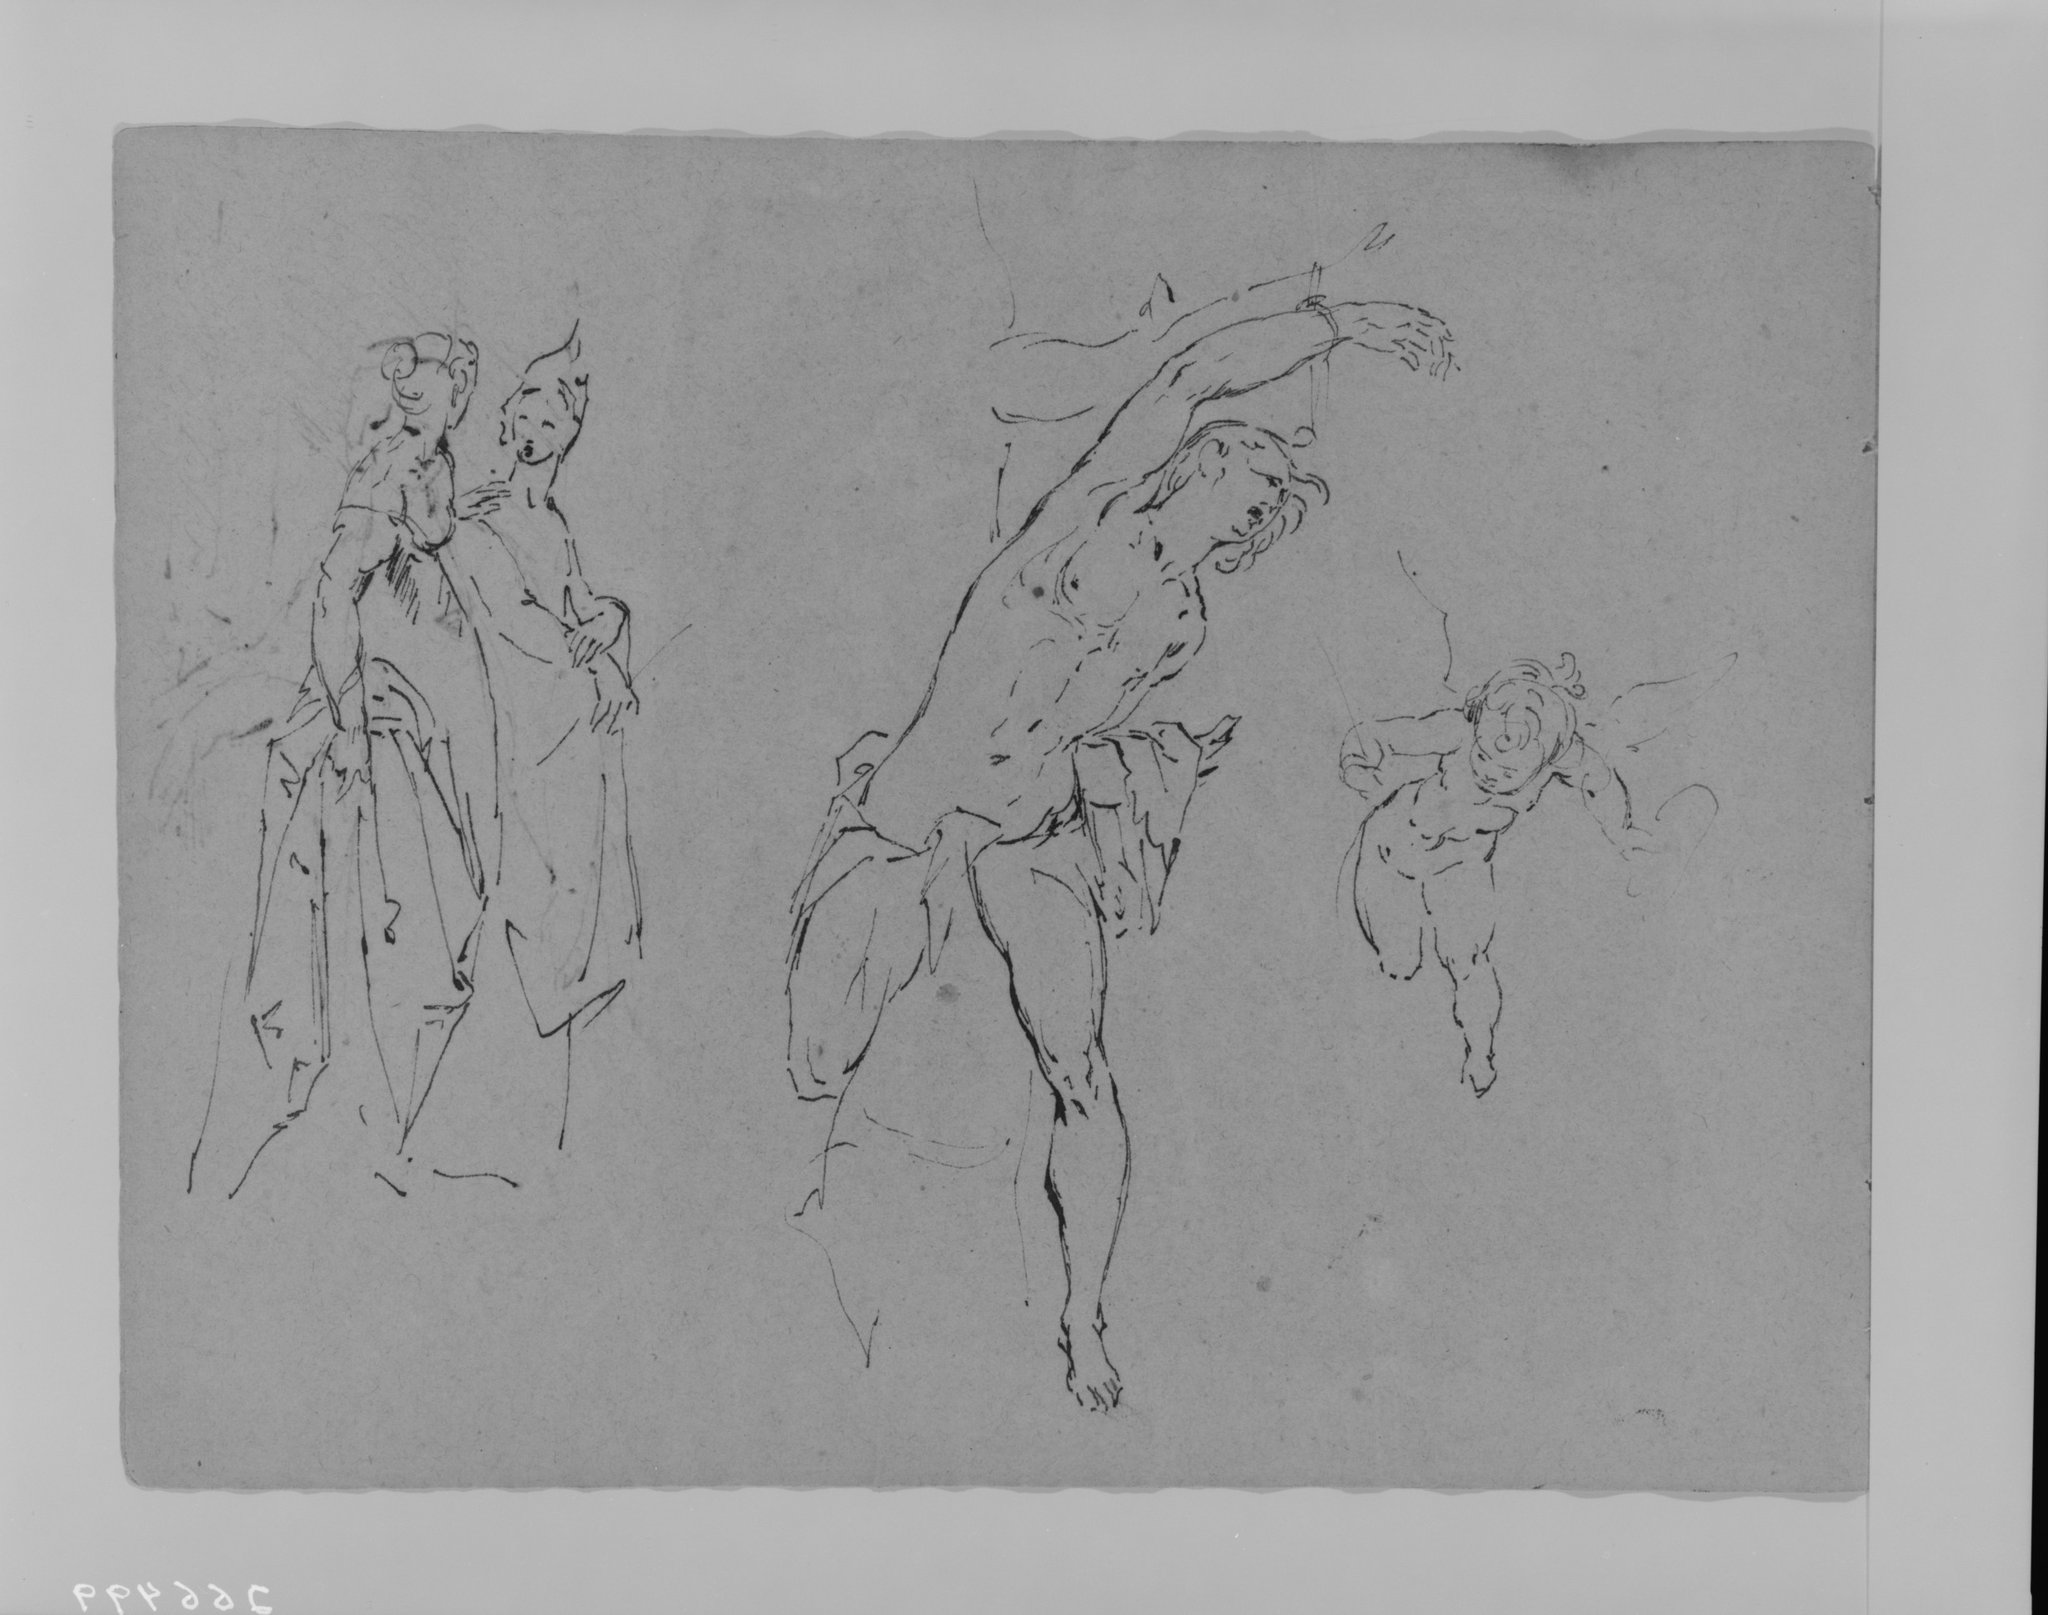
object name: drawing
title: (From Sketchbook)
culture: american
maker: thomas sully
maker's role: artist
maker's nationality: american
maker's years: 1783-1872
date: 1810-1820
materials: ink, paper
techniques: wash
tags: men,women,angels